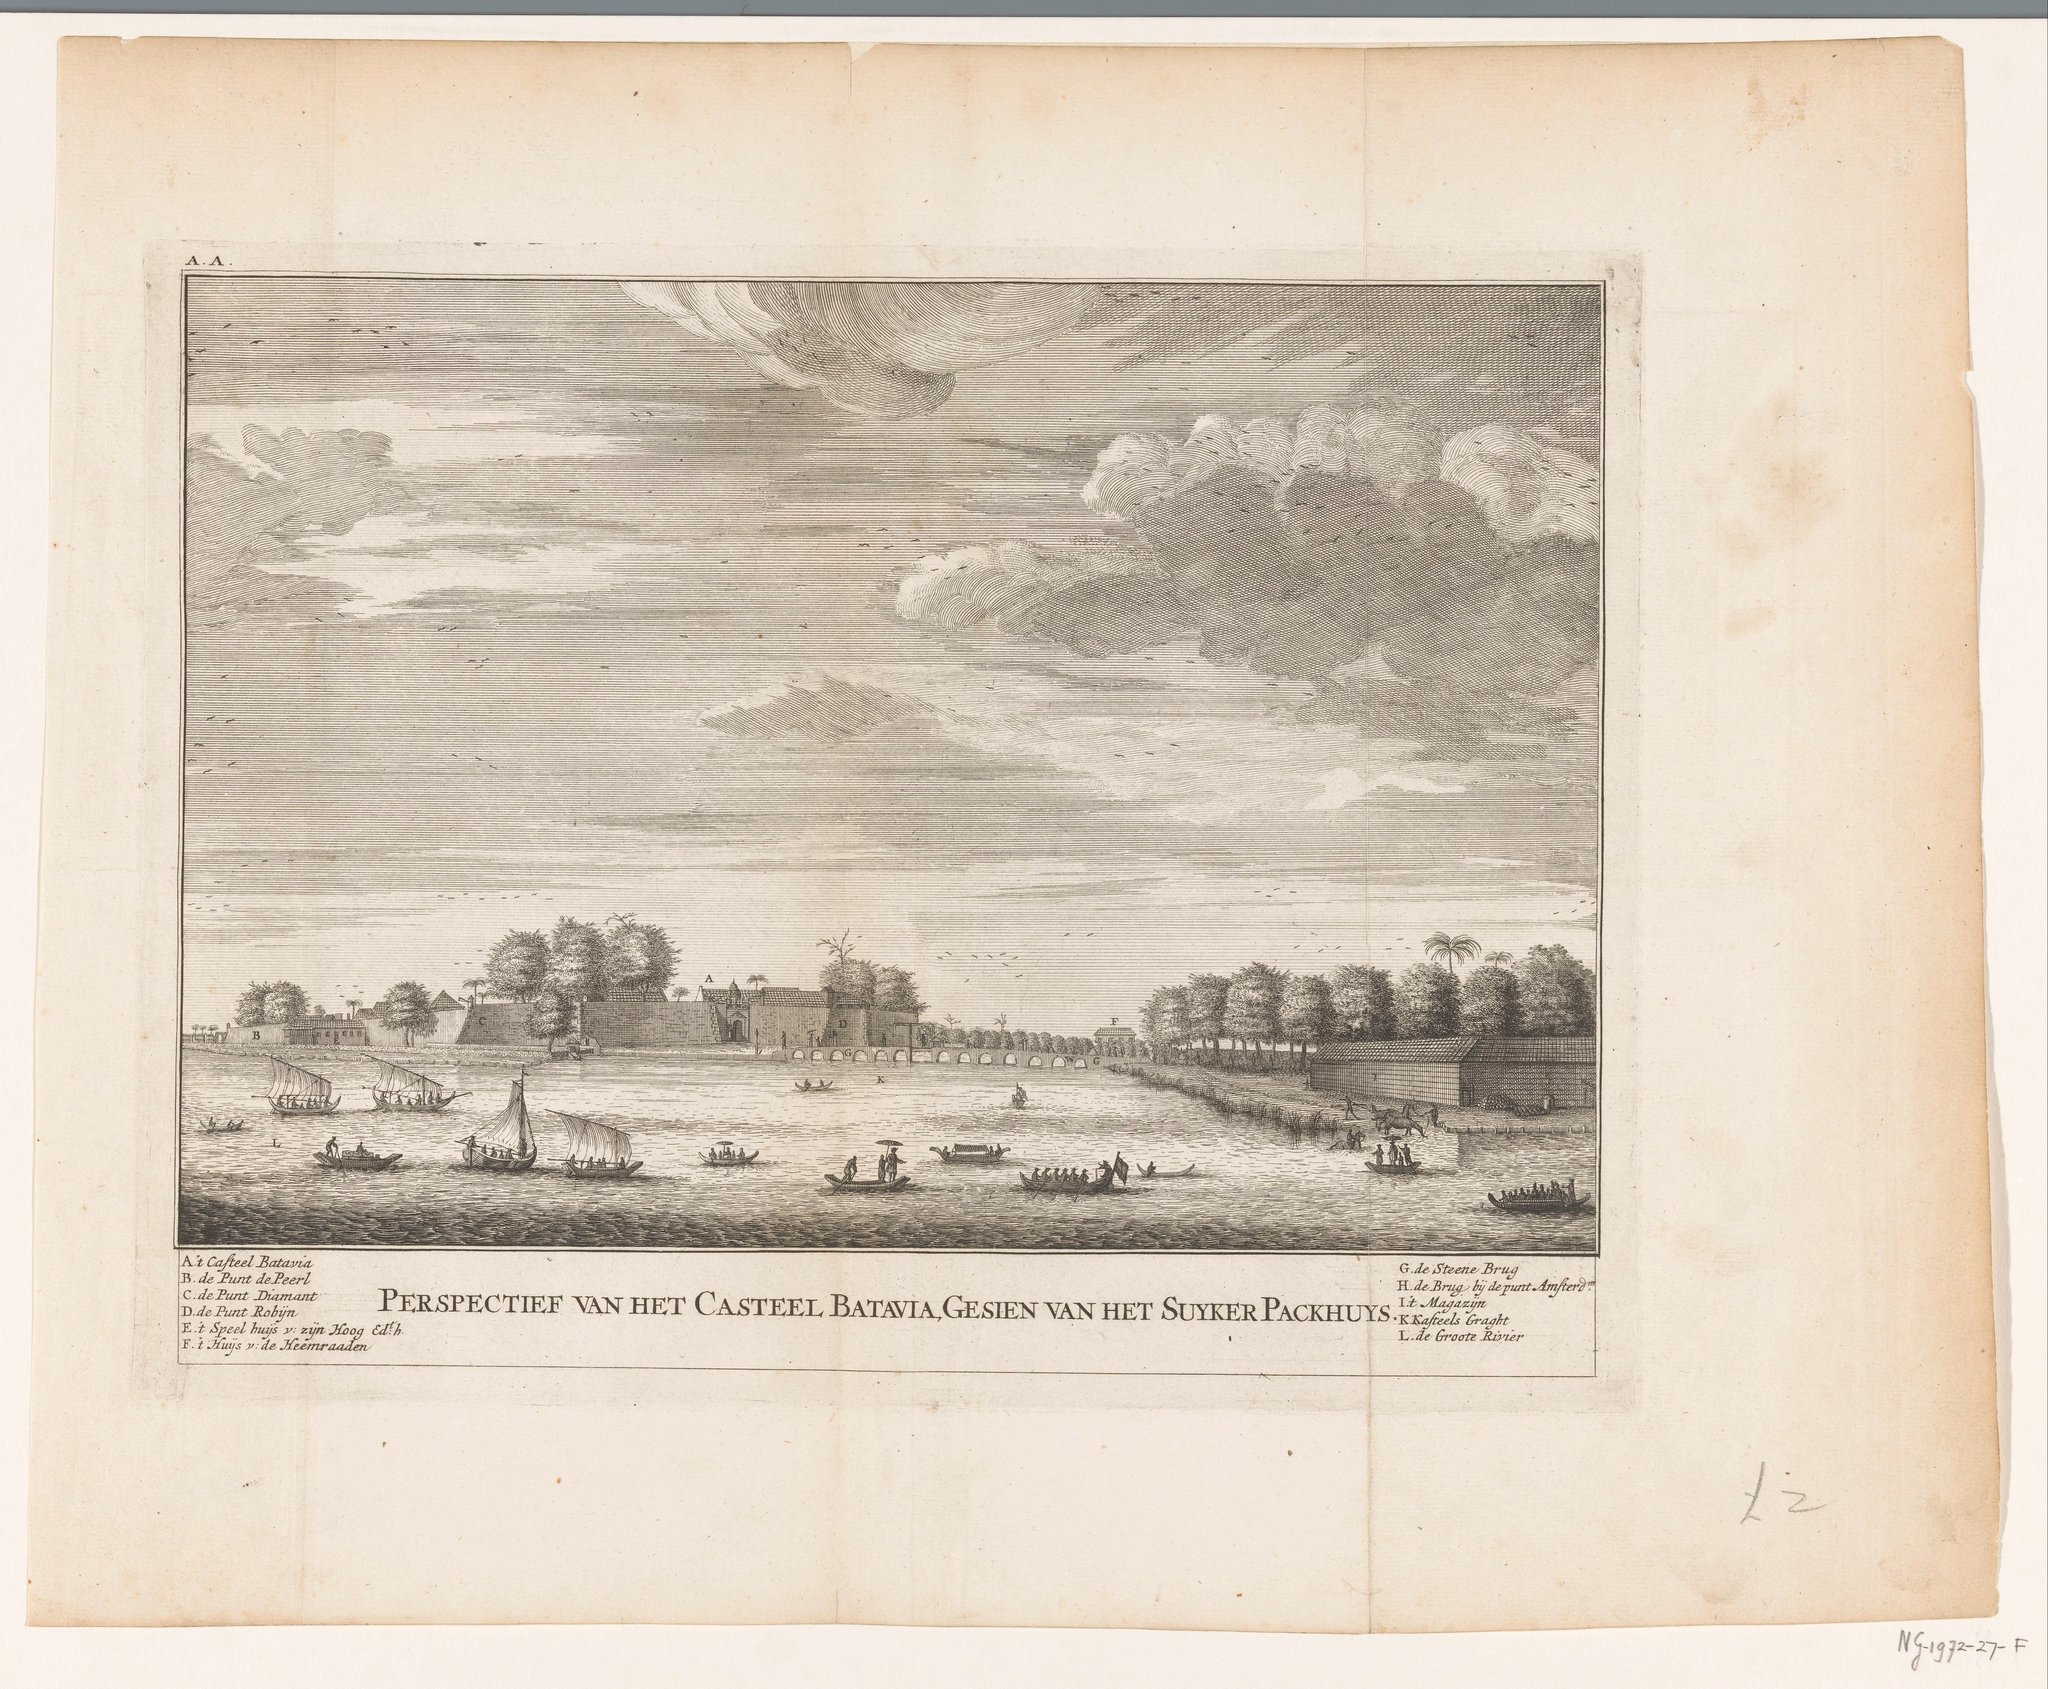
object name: print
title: Gezicht op het kasteel te Batavia, gezien vanaf het suikerpakhuis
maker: Anonymous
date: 1720-1724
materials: paper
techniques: engraving, etching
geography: northern netherlands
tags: fortress, landscapes in tropical and sub-tropical regions, river (+ landscape with figures, staffage)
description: Gezicht op het Kasteel Batavia ca. 1720, aan een rivier, waarop verschillende zeilschepen en roeiboten. Ophaalbrug over de slotgracht. Rechts een groot gebouw waarachter een rij bomen. In de onderschrift de legenda A-L. Genummerd linksboven: A.A.